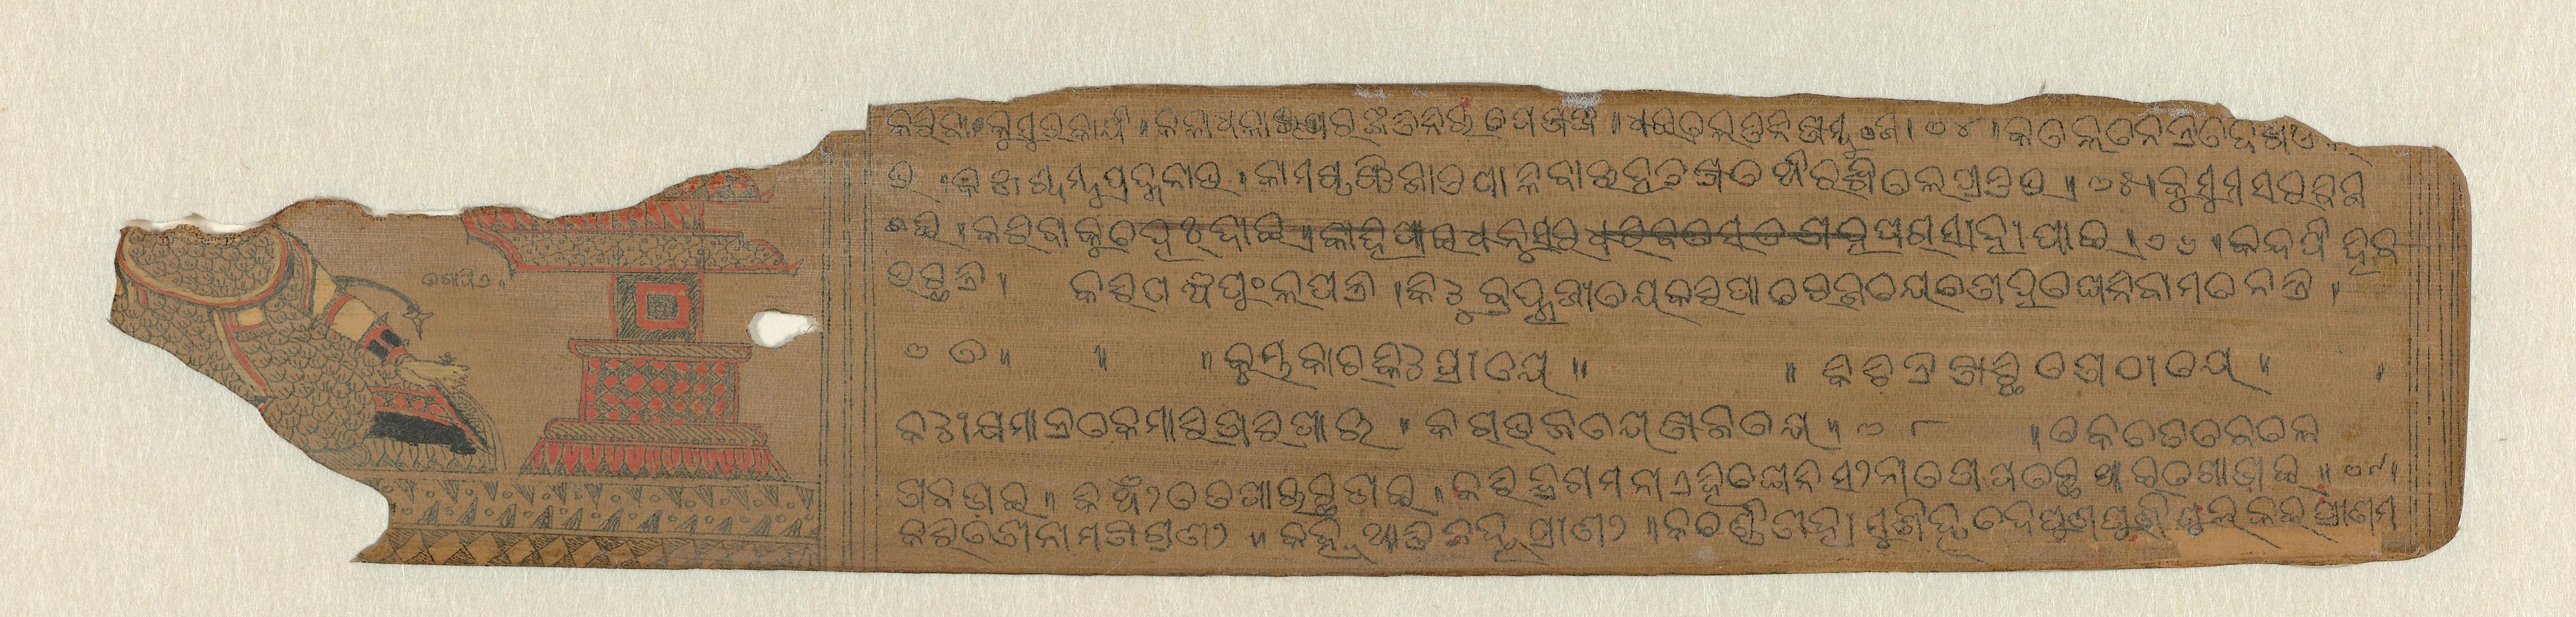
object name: drawing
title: Liefdesscène van Krishna en Radha in het bos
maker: Anonymous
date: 1800-1900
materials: cardboard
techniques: brush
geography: odisha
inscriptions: inscription: ‘.’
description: Op het onregelmatige stukje karton lopen Krishna en Radha vanaf de linkerkant een bos binnen waarin allerlei dieren tussen de takken van de bomen te zien zijn. Onregelmatig stuk karton met links ponsgaatje en aan de linkerkant uitlopend in een smallere punt.